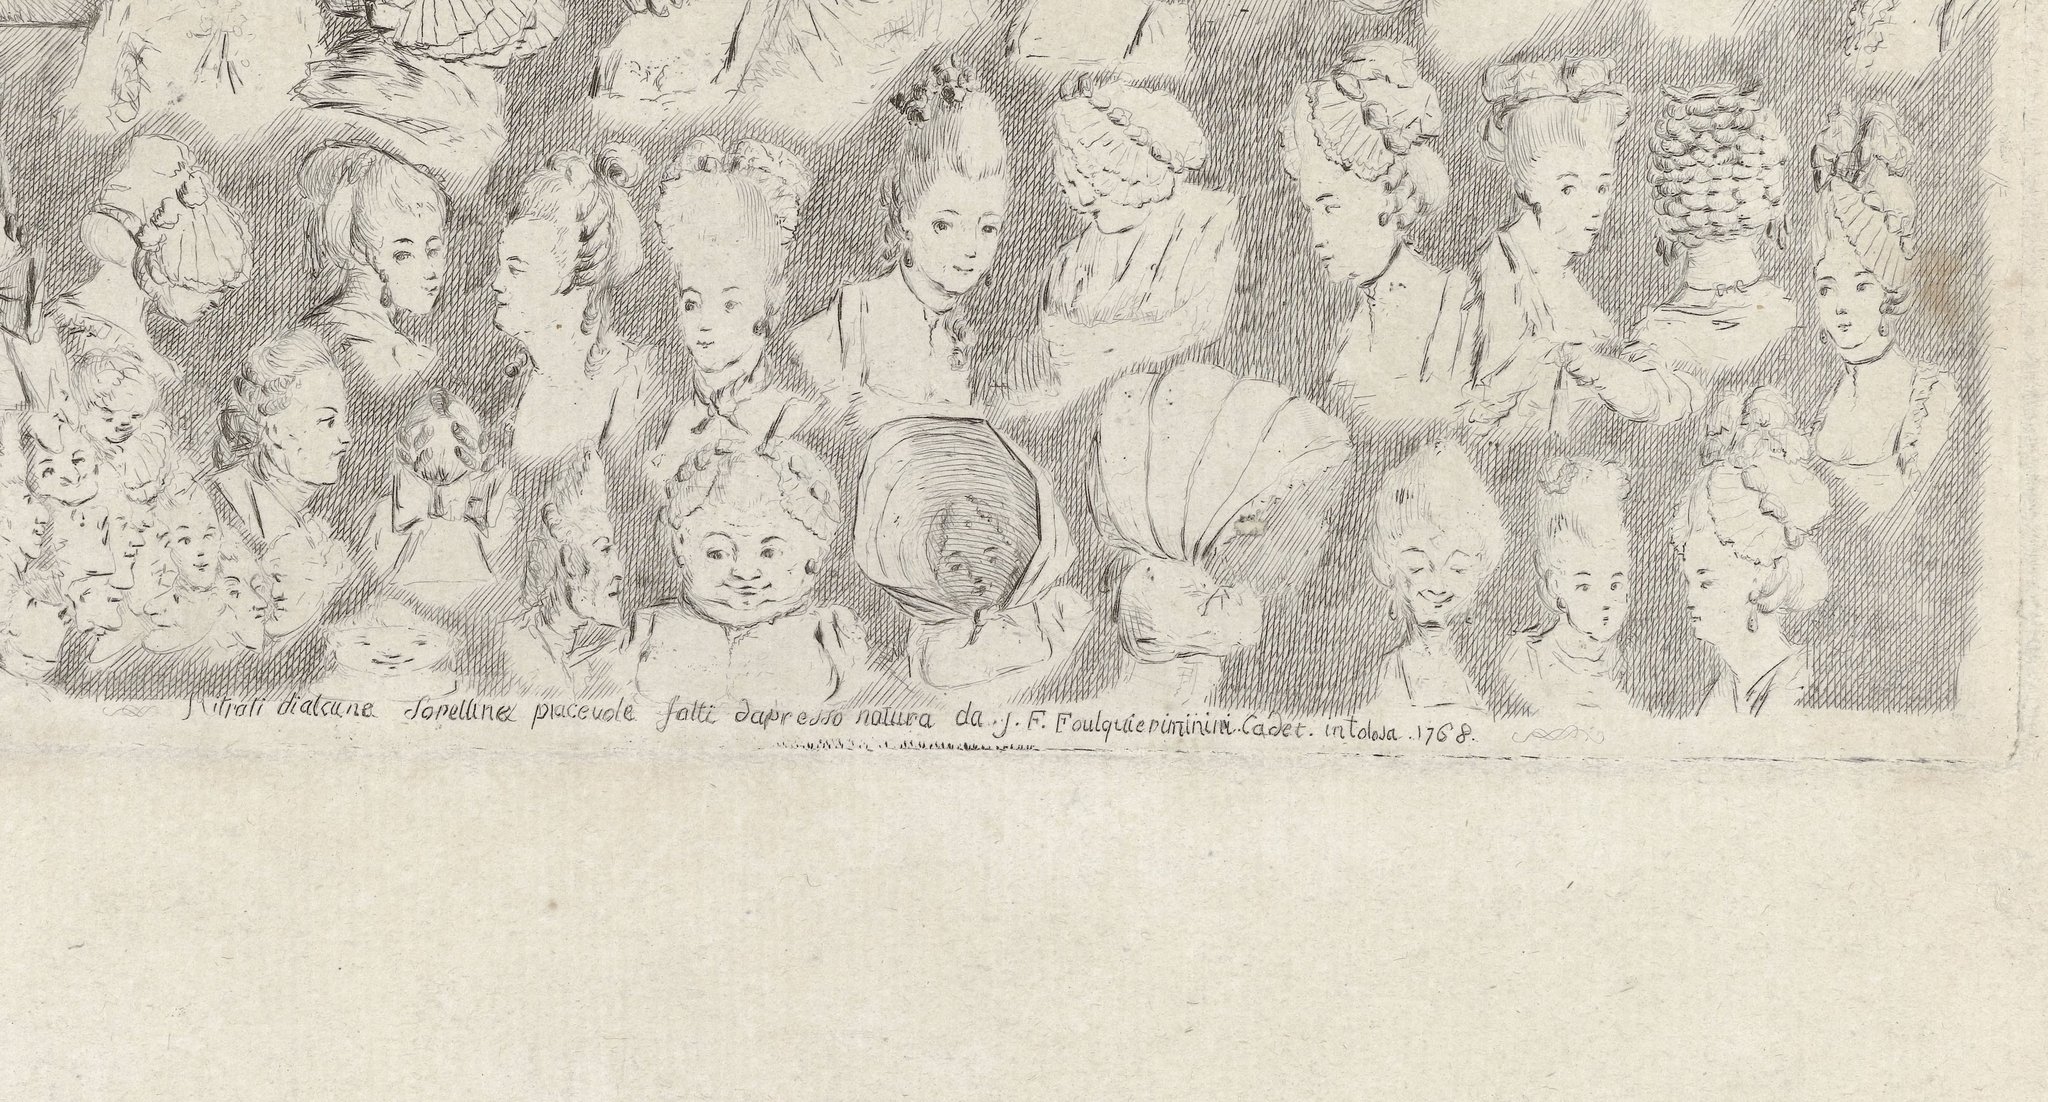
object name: print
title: Verschillende hoofden en kapsels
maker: joseph françois foulquier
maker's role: print maker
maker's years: 1744-1789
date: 1768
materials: paper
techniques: drypoint, etching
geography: toulouse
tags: head (human), styles of hairdress - aa - ~ women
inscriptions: collector's mark: ‘Douane Centrale. La Portation Paris’, collector's mark: Lugt 2228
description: De prent staat in de Inventaire du Fonds Français (dl. 9, p. 272) onder de naam Foulquier Cadet. Dit zou een jongere broer kunnen zijn van Joseph François Foulquier, maar het kan ook Joseph François Foulquier zelf zijn. Botke, K.